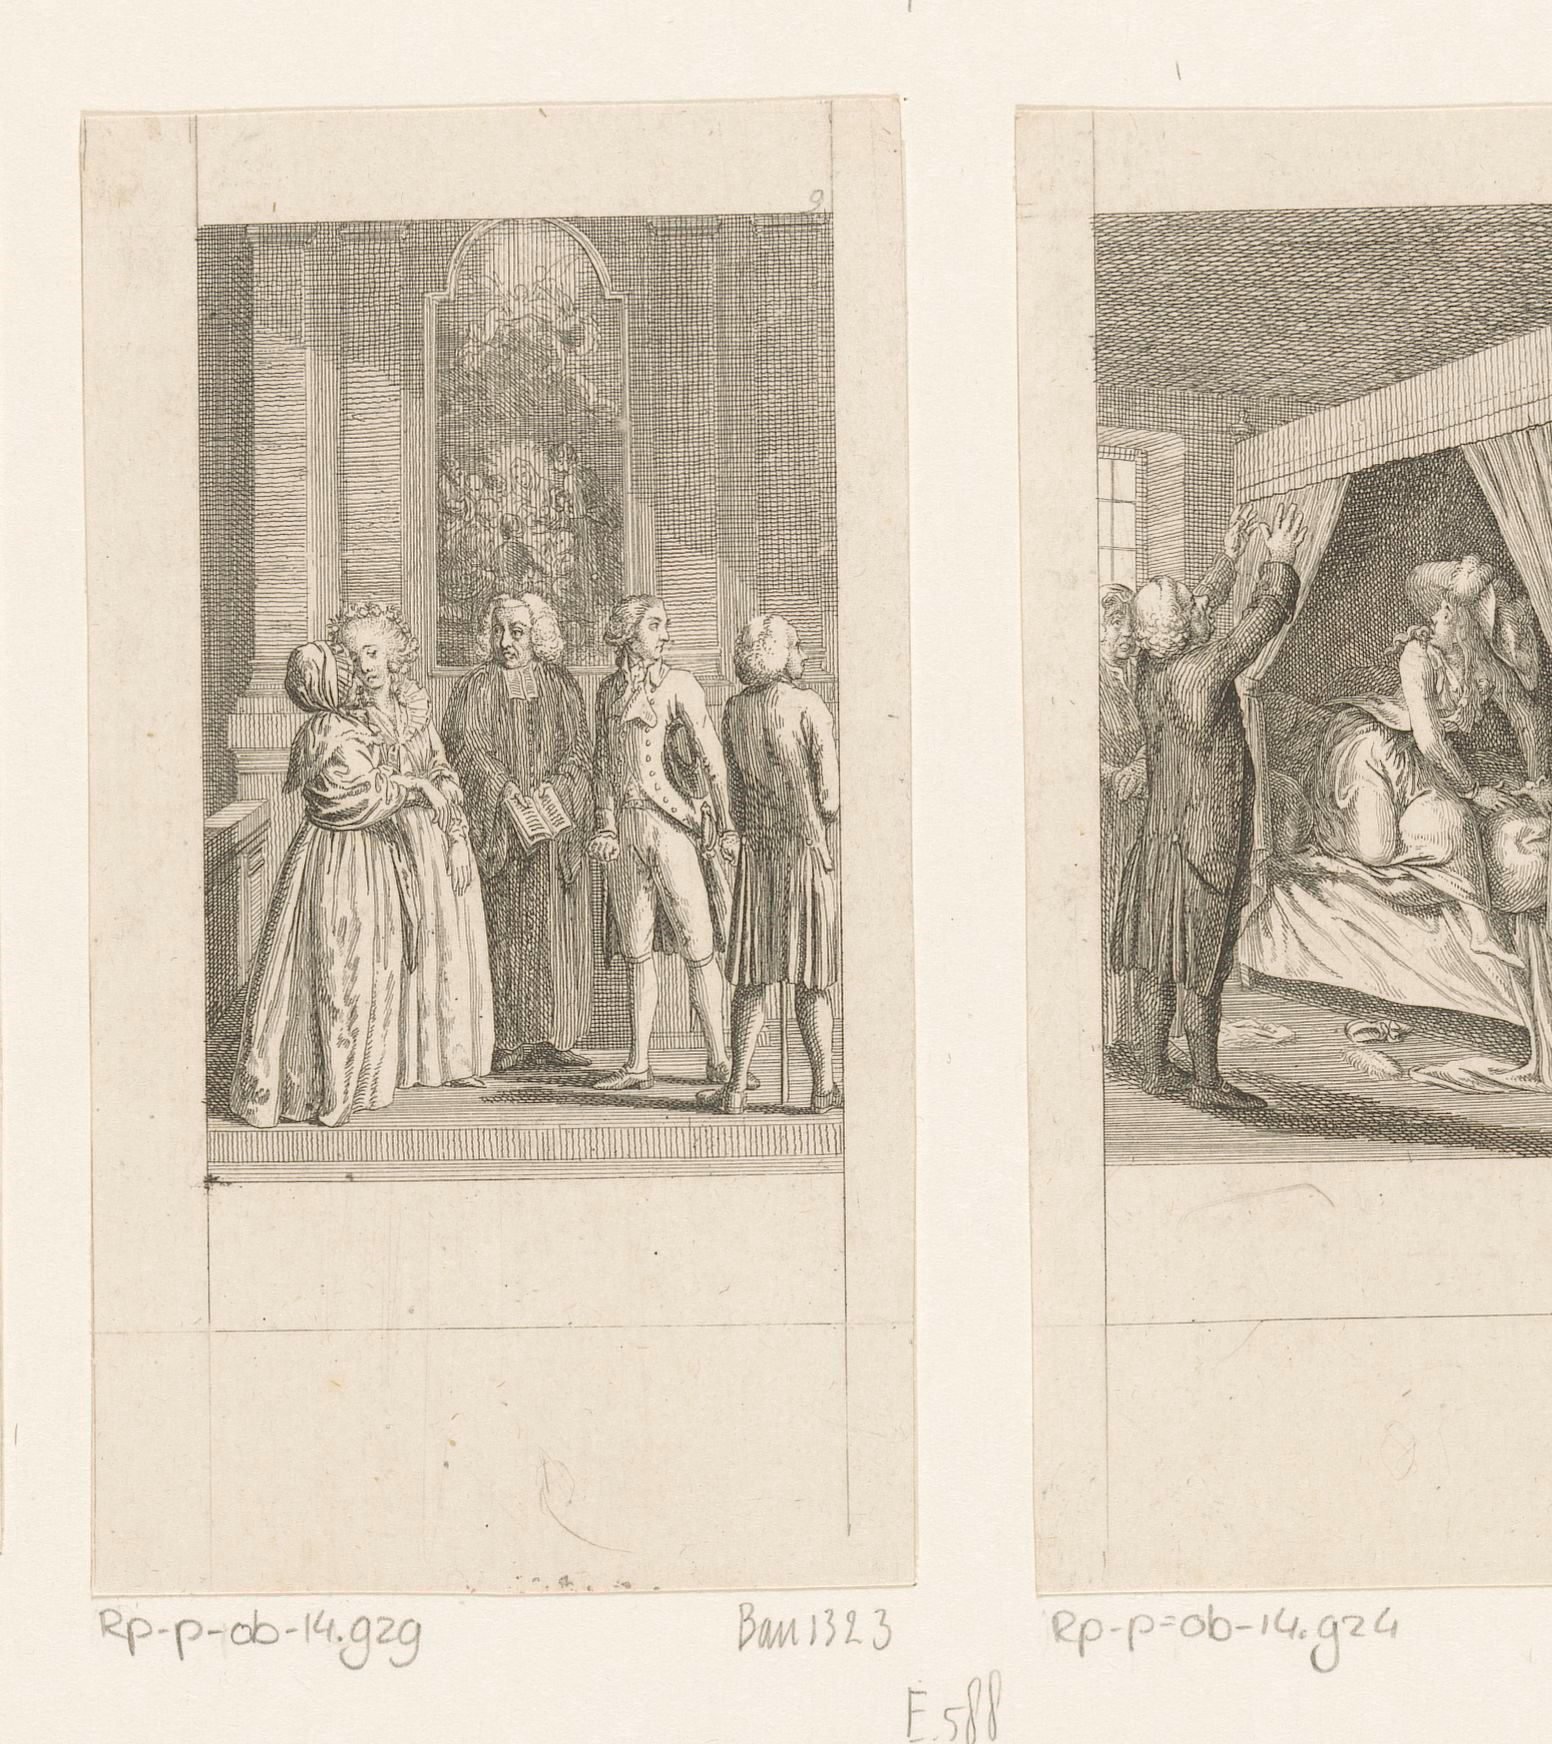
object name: print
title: Verstoring van de huwelijksgeloften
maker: daniel nikolaus chodowiecki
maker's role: draughtsman, print maker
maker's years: 1726-1801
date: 1787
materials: paper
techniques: etching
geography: berlin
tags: london, literature, nativity scene ~ equipment of church, interior of the house, weeping, (civil) marriage ceremonies (+ variant)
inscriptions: collector's mark: Lugt 2228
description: Vervaardigd voor een bewerking van Frances Burney's 'Cecilia', genaamd 'Cecilia oder die Geschichte einer reichen Waise'. Latere staat van deze prent gebruikt in: Königl. Grosbritannischer Historischer Genealogischer Calender für 1789, mit Kupfern von Chodowiecki. Lauenburg: J. G. Berenberg, 1788.